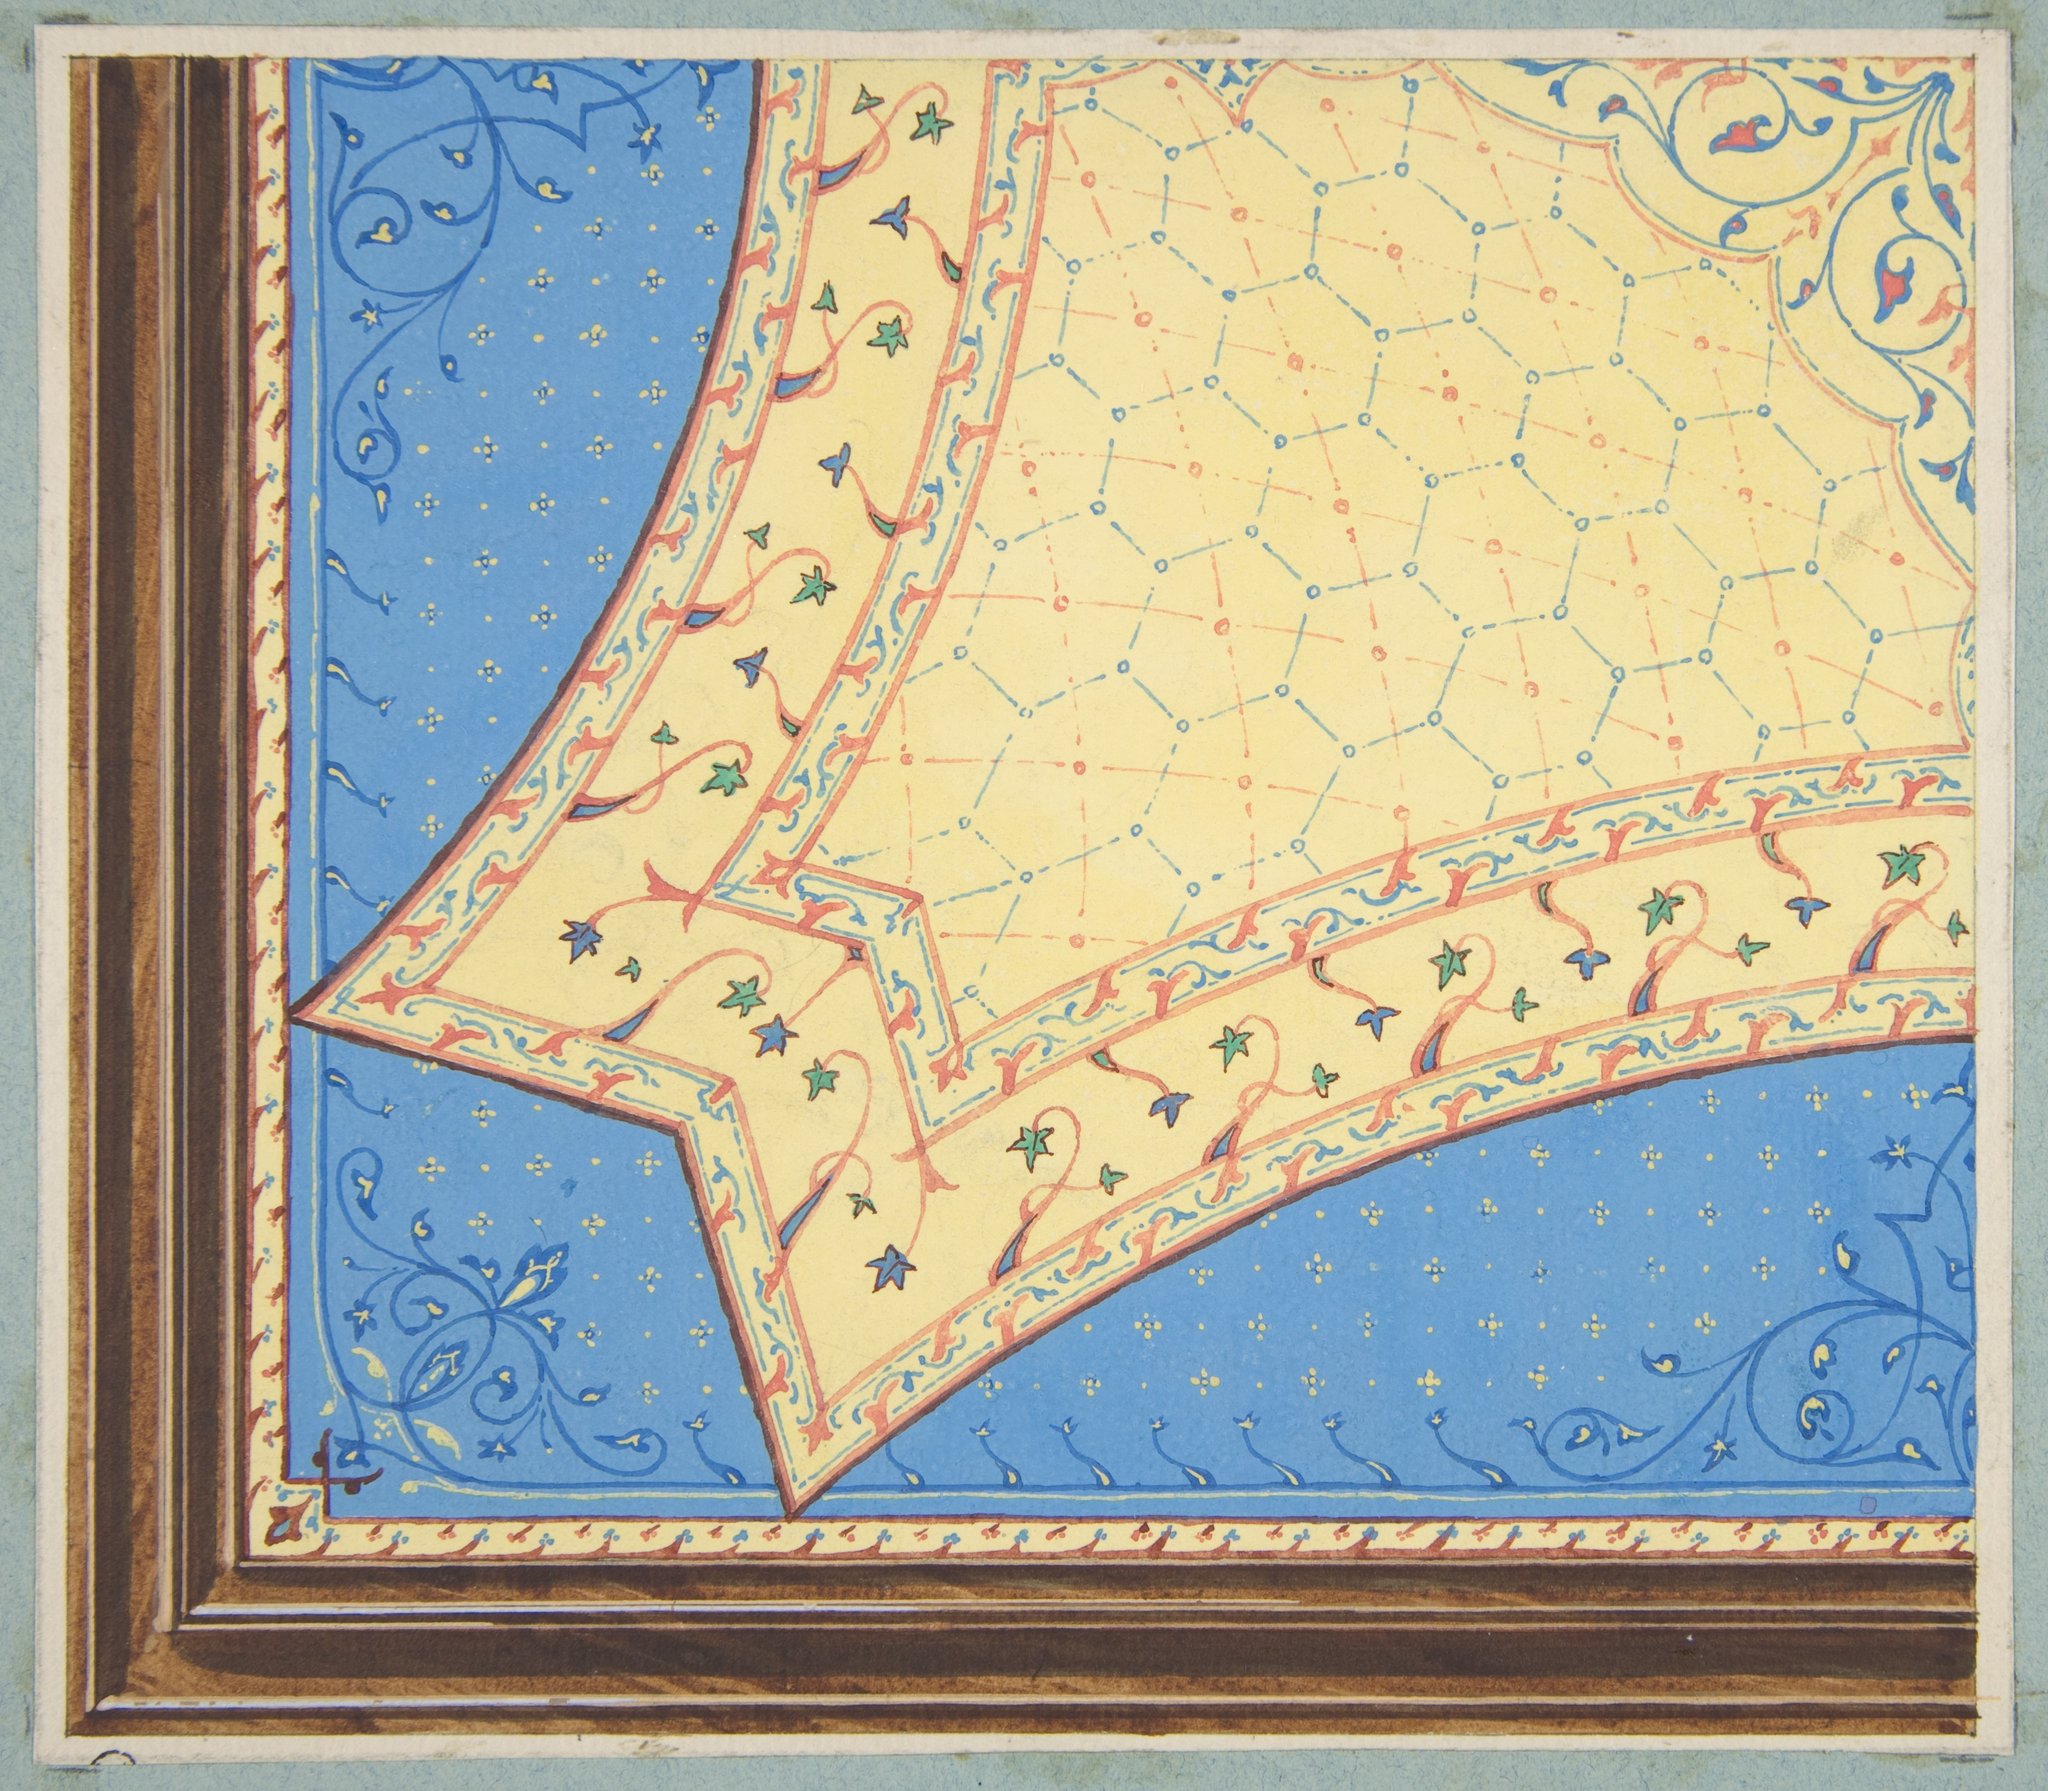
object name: drawing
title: Design for the painted decoration of a ceiling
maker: jules-edmond-charles lachaise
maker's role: artist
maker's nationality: french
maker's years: 1897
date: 1851-1900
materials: gouache, paper, watercolor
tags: ceilings